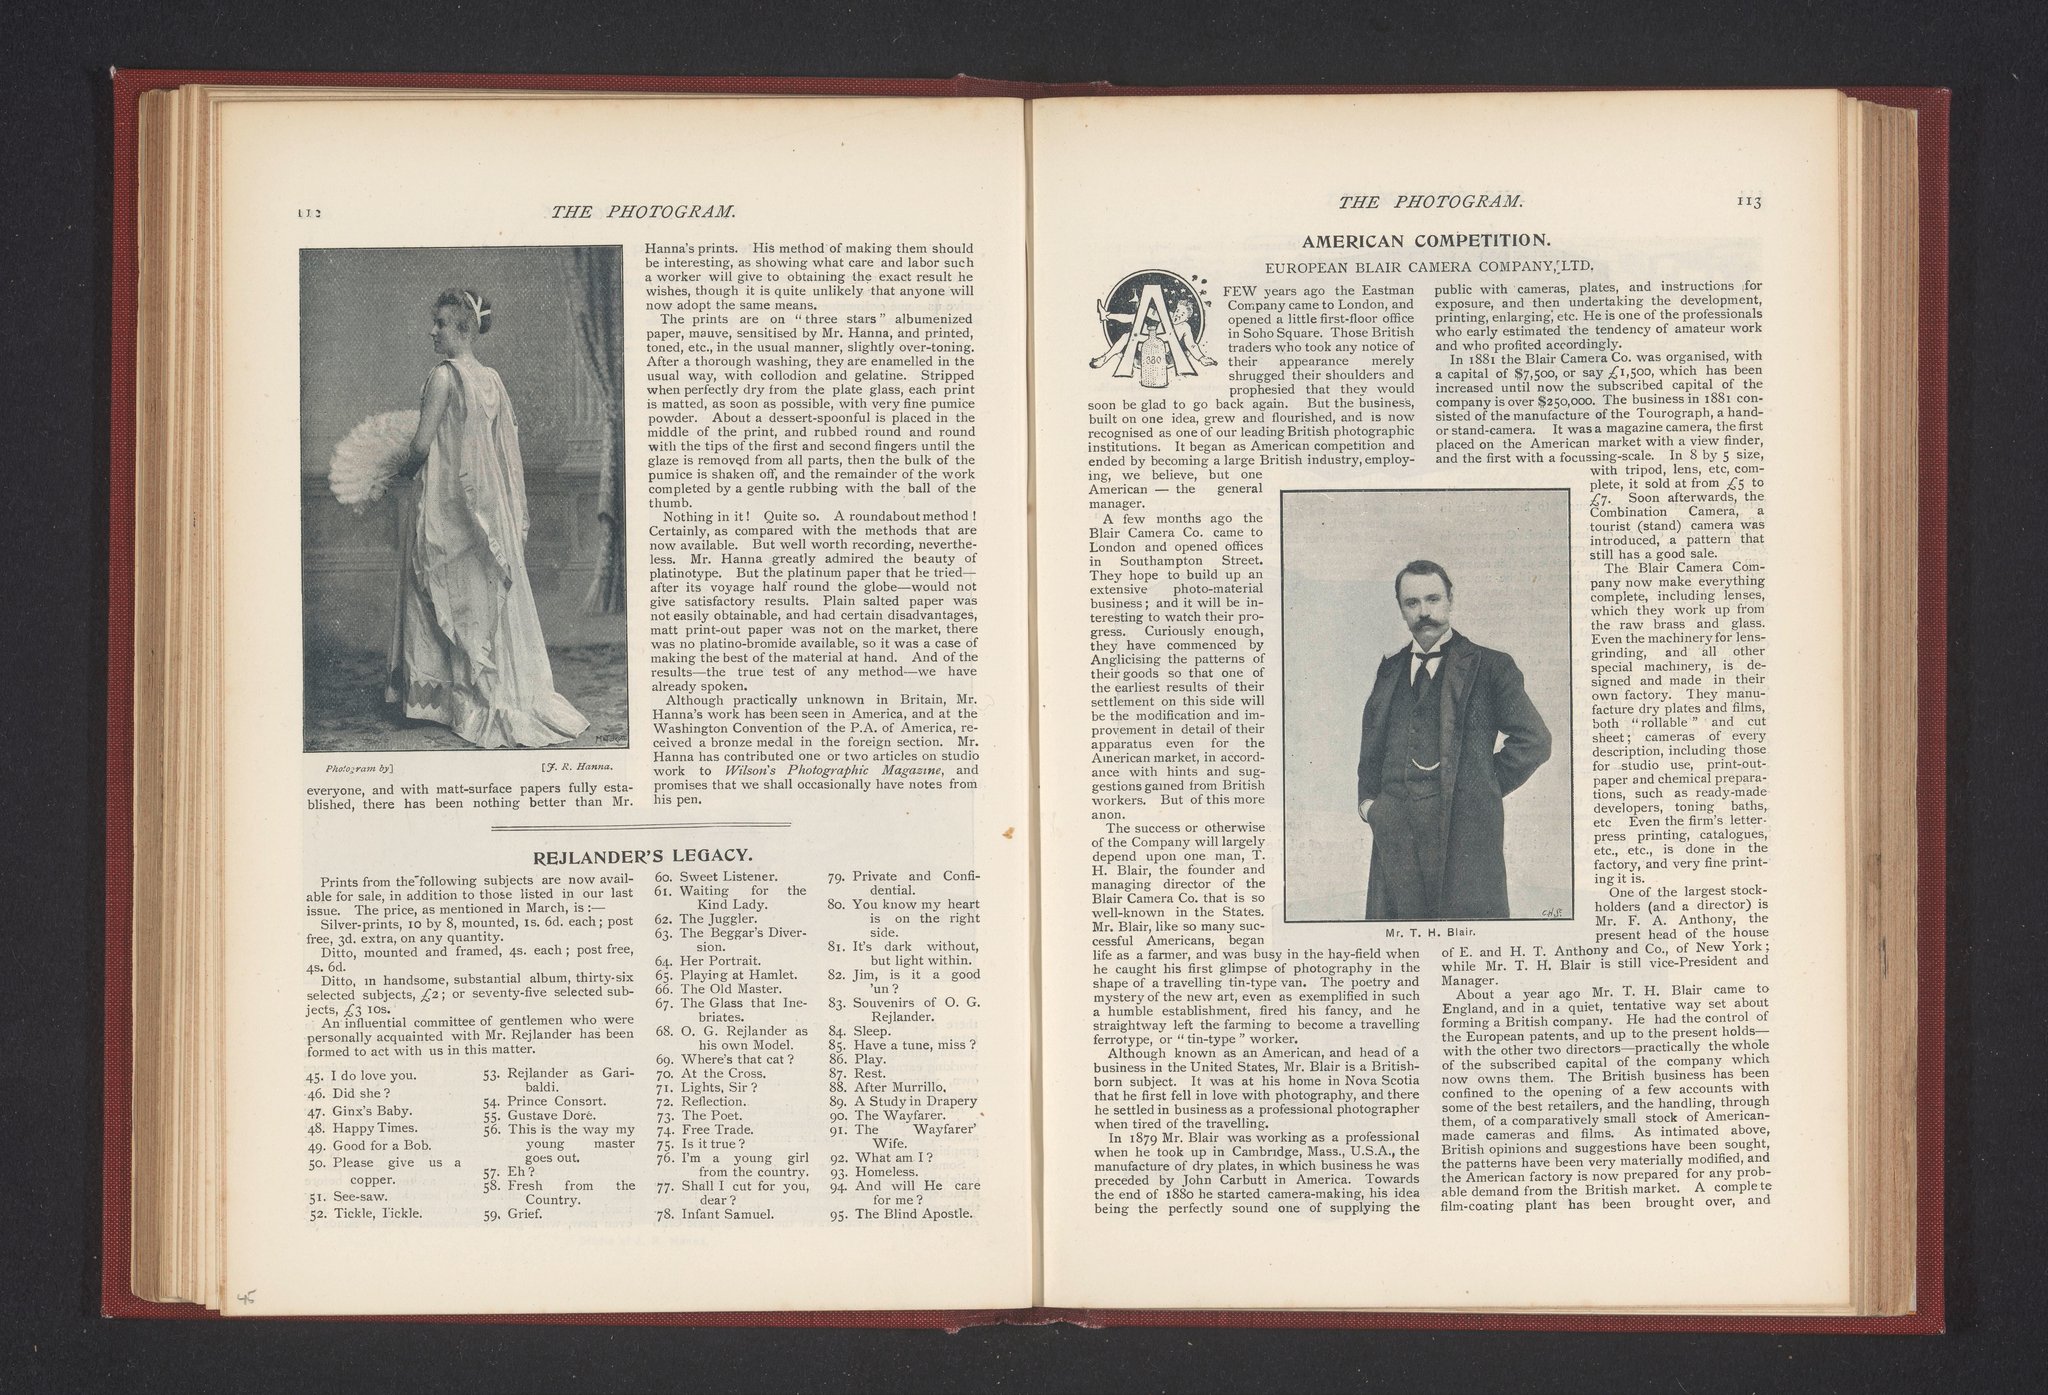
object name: photomechanical print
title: Portret van een onbekende vrouw in een jurk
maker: j.r. hanna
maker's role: fotograaf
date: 1889-1894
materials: paper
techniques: autotype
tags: historical persons - bb - woman